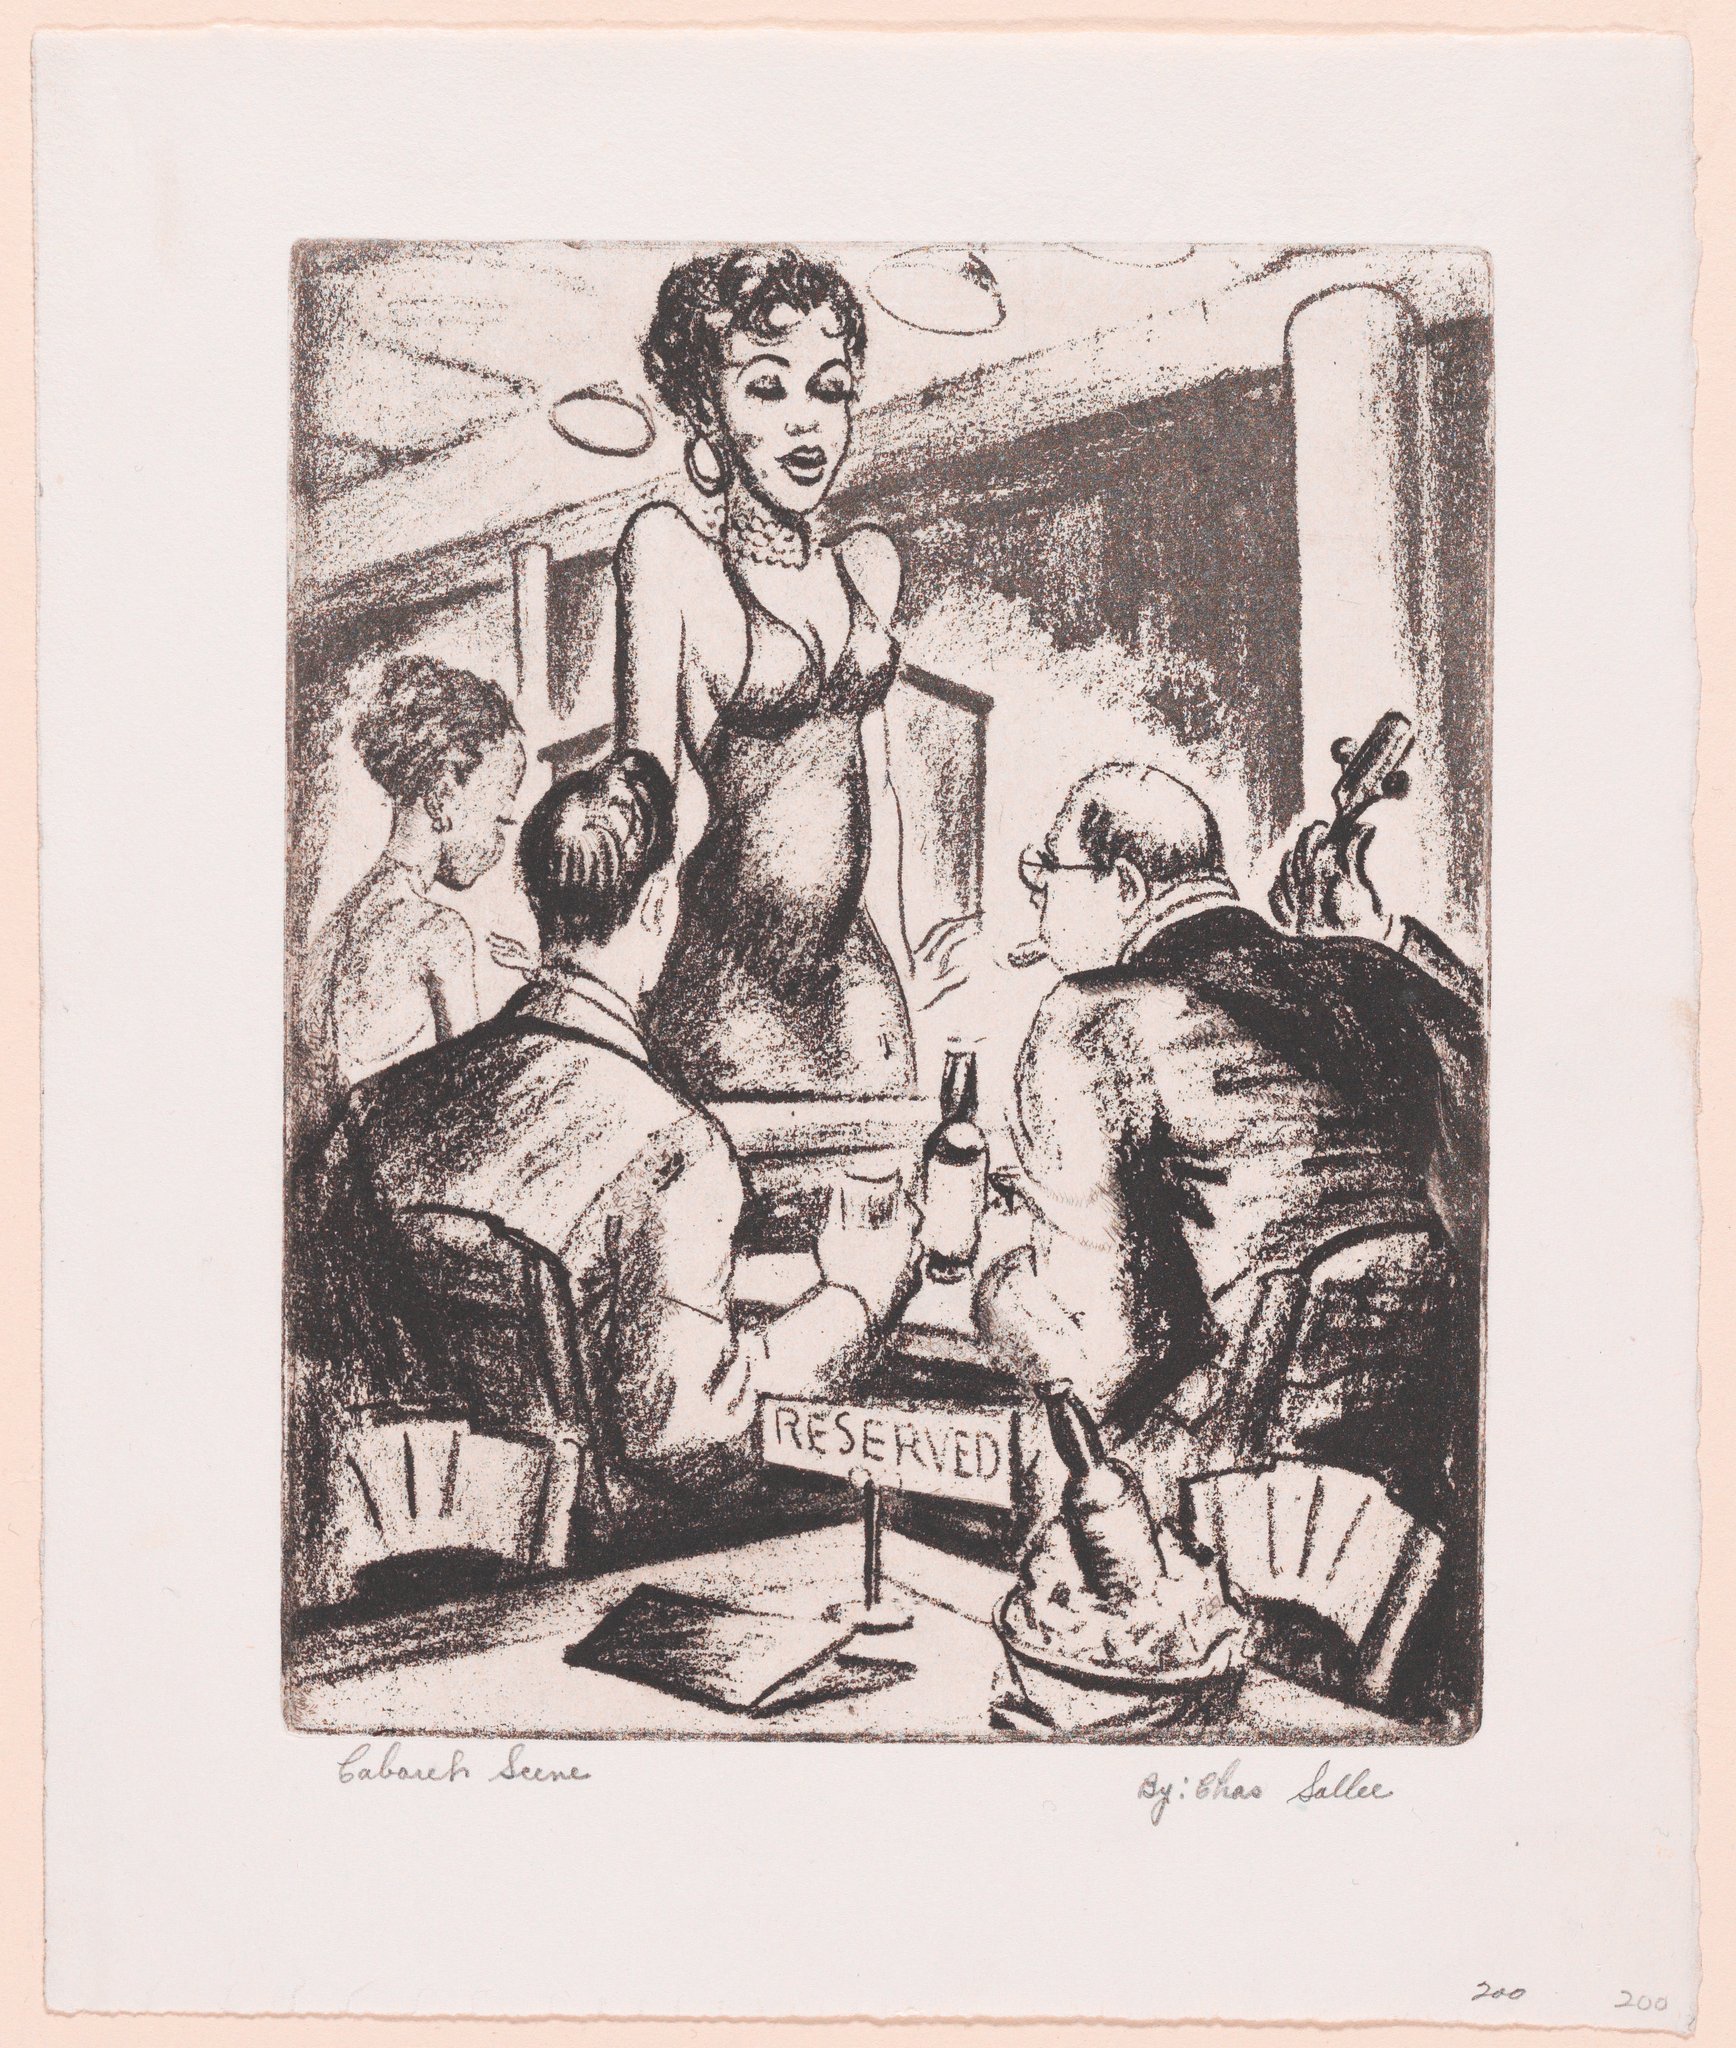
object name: print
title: Cabaret Scene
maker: charles l. sallee, jr.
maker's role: artist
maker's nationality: american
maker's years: 1913-2006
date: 1936-1941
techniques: etching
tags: men,women,drinking,tables